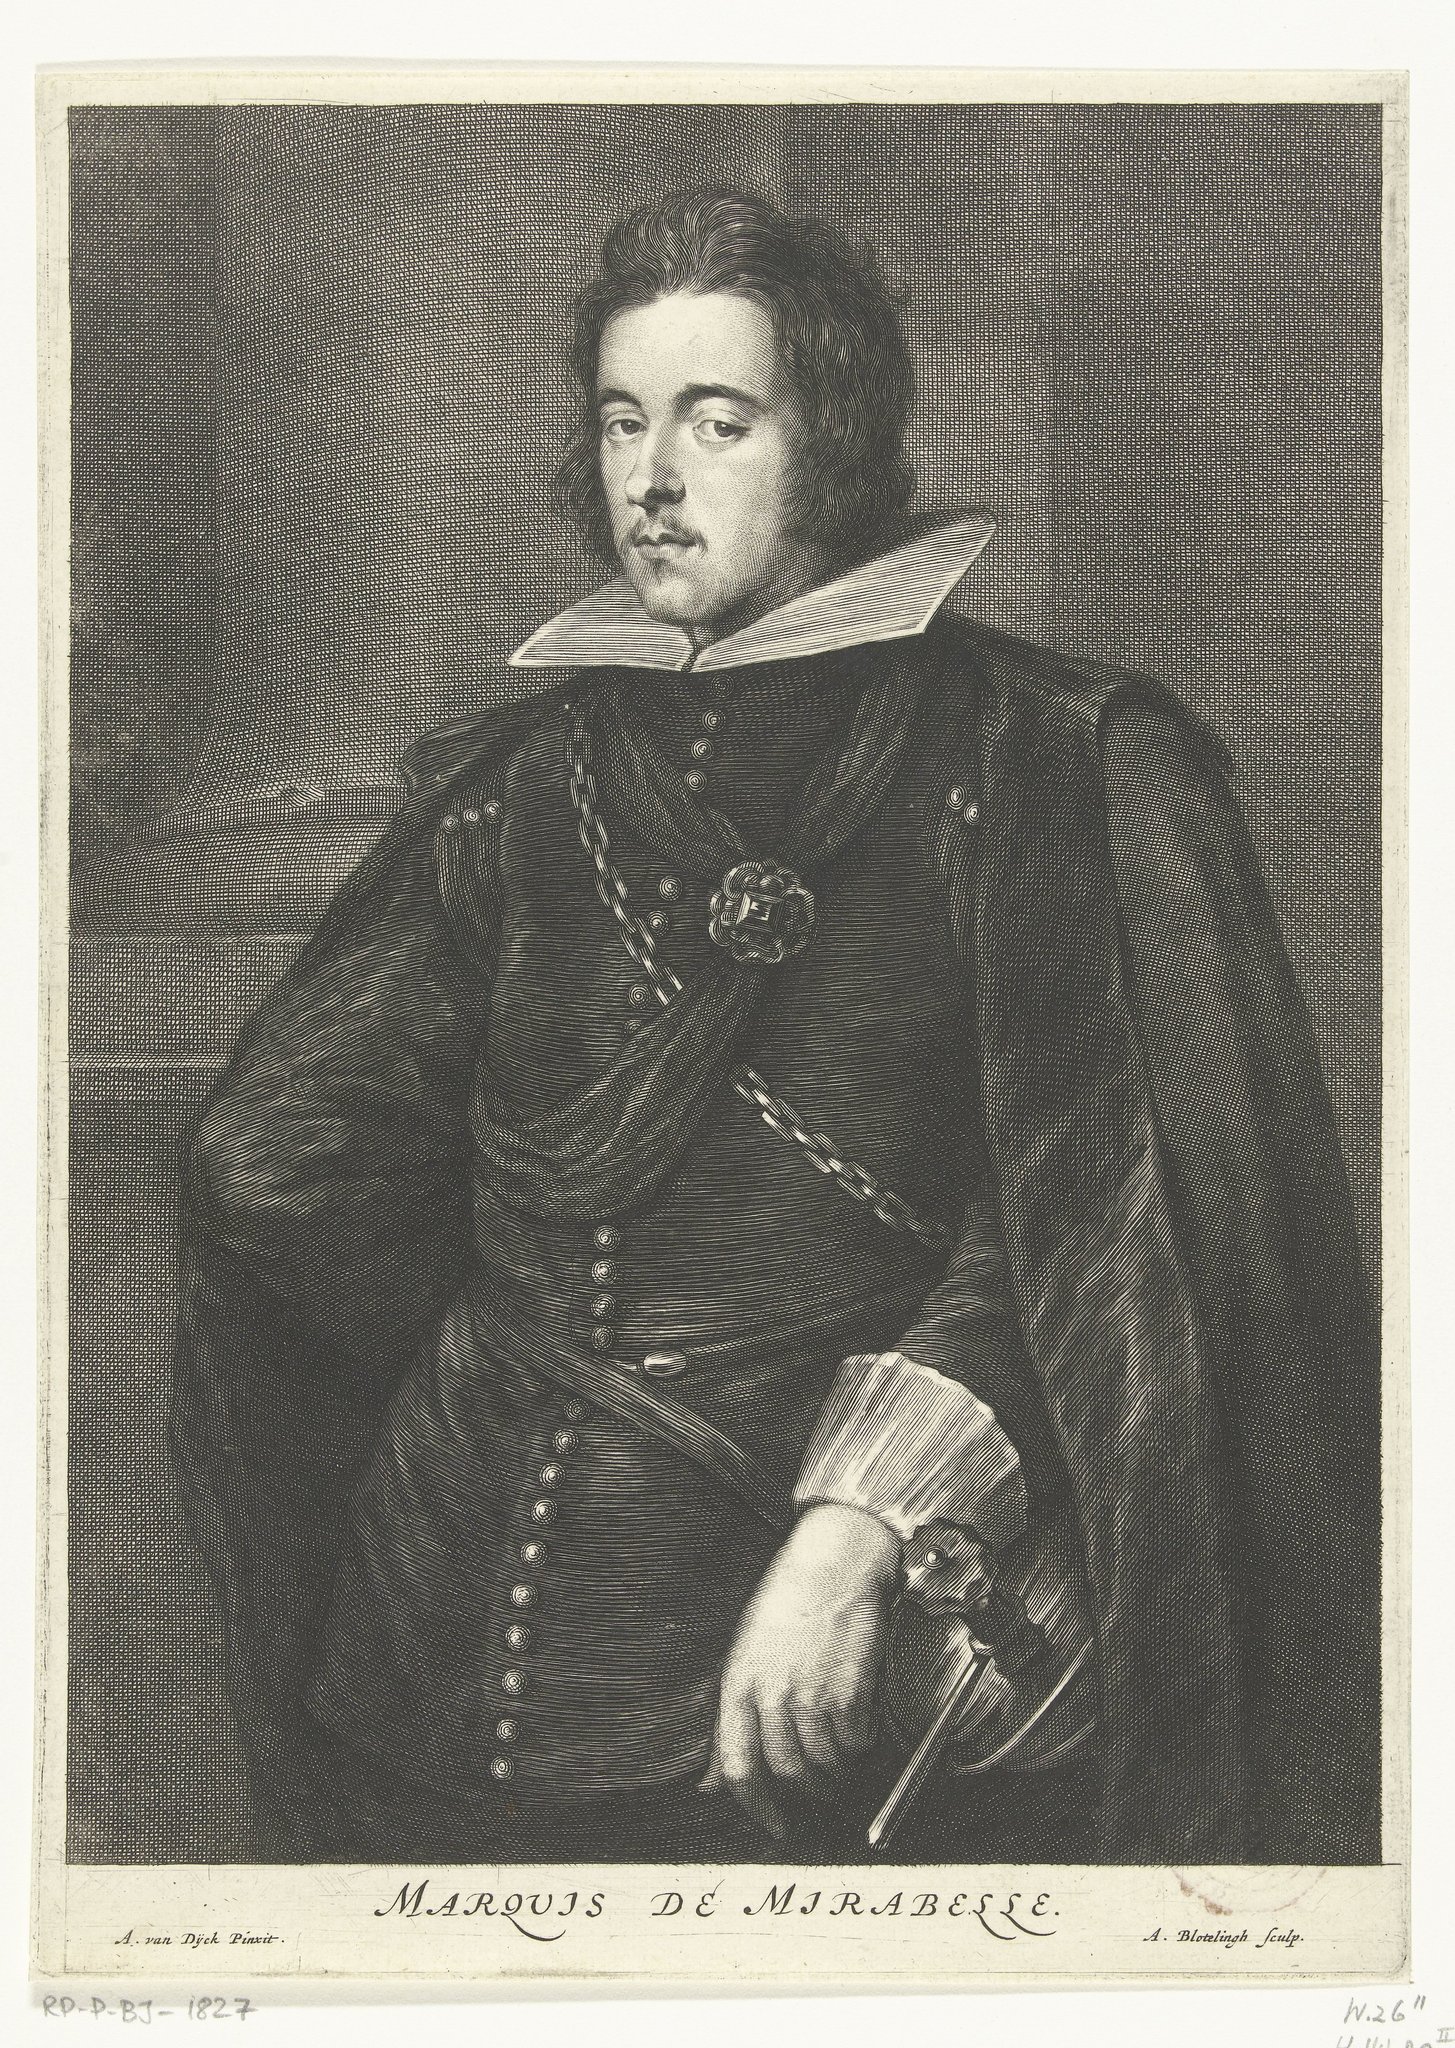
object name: print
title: Marquis de Mirabelle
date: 1675-1690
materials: paper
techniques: engraving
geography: netherlands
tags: paris, honoré-gabriel de riqueti (graaf van mirabeau), ambassador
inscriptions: collector's mark: Lugt 240, collector's mark: Lugt 2228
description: Portret van Honoré de Riqueti marquis de Mirabeau, Spaanse ambassadeur in Parijs als jonge man.